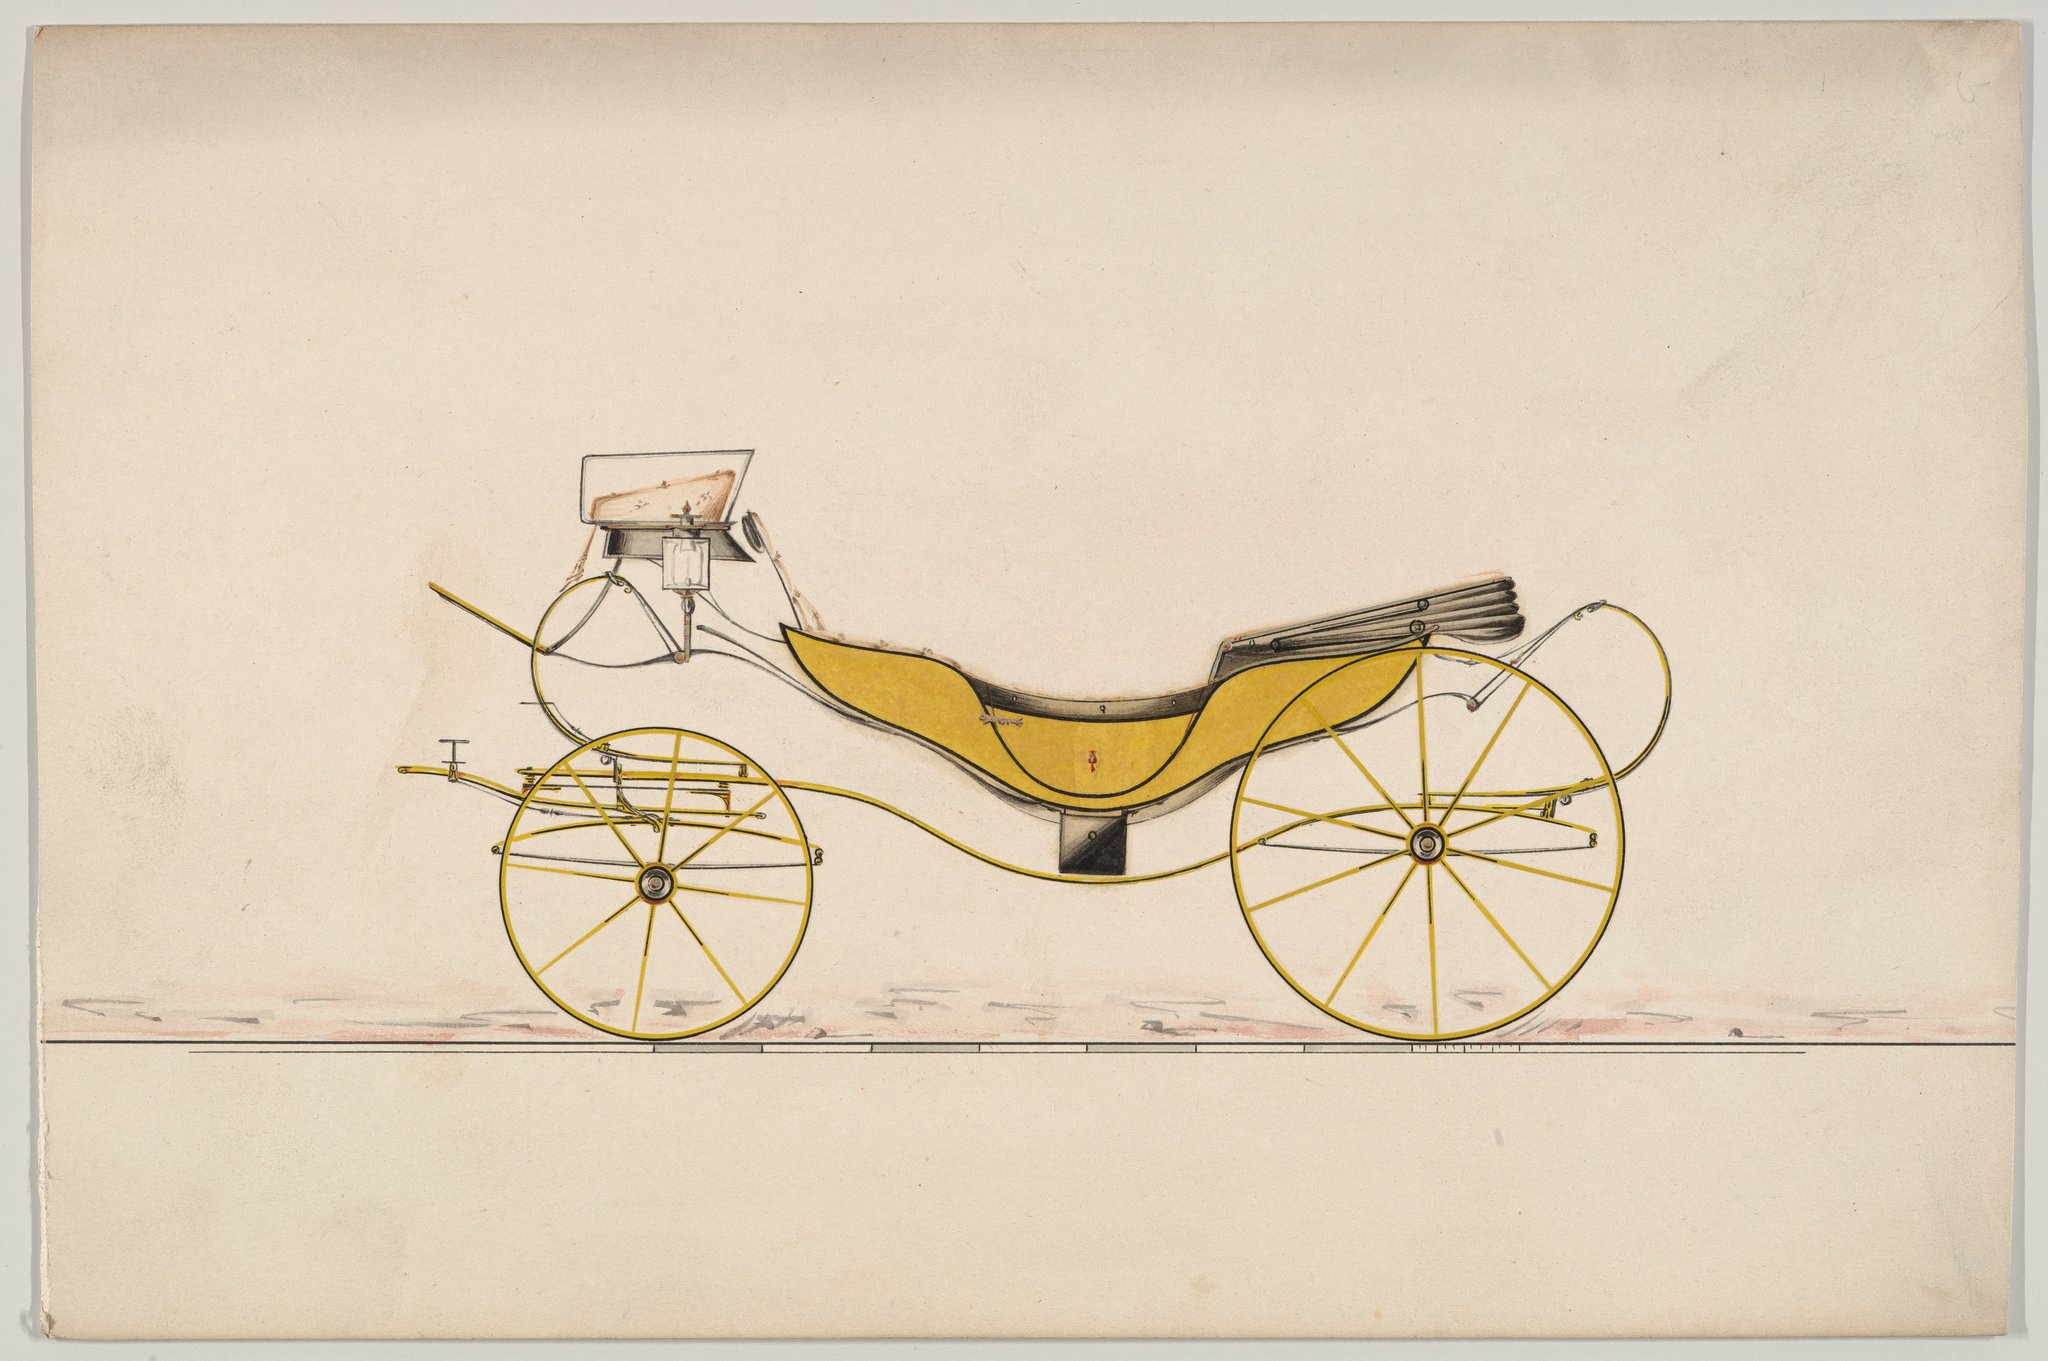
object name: drawing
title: Caleche (unnumbered)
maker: brewster & co.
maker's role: manufacturer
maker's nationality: american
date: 1850-1870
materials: gouache, gum arabic, ink, watercolor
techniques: pen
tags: carriages